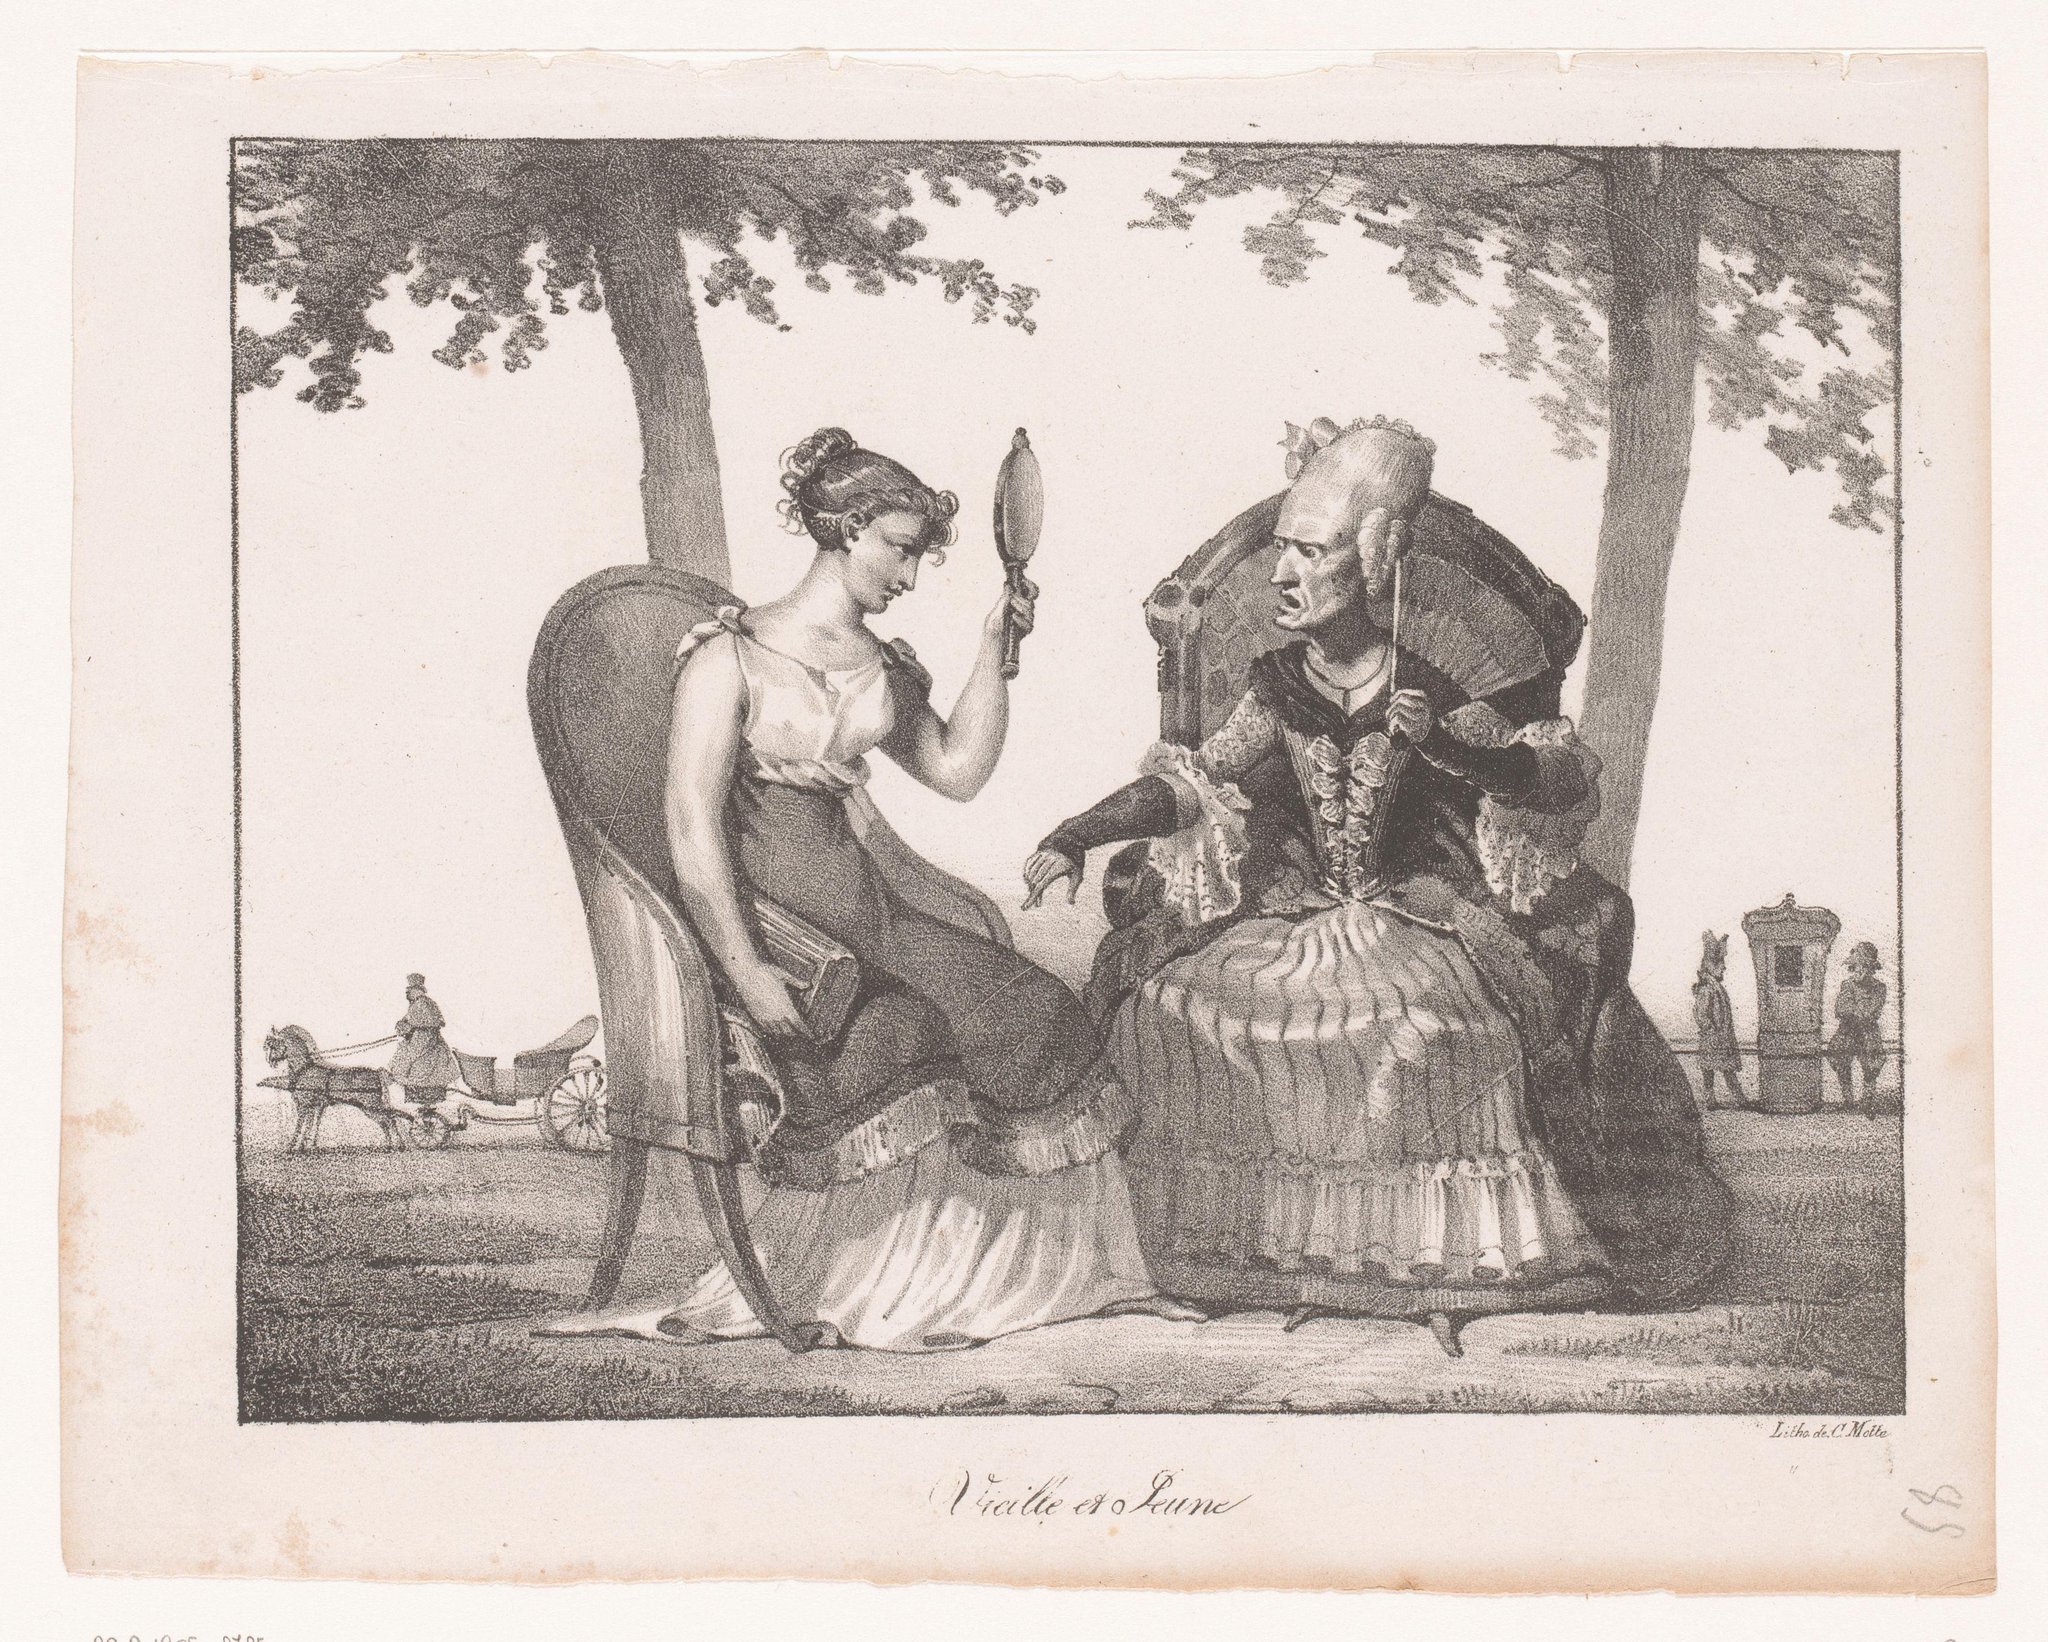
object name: cartoon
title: Vieille et Jeune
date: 1817-1837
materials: paper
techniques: lithograph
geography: paris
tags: four-wheeled vehicle drawn by one animal, (carrying a person on a) litter, stretcher, mirror, young versus old age; young and old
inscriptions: collector's mark: Lugt 2228